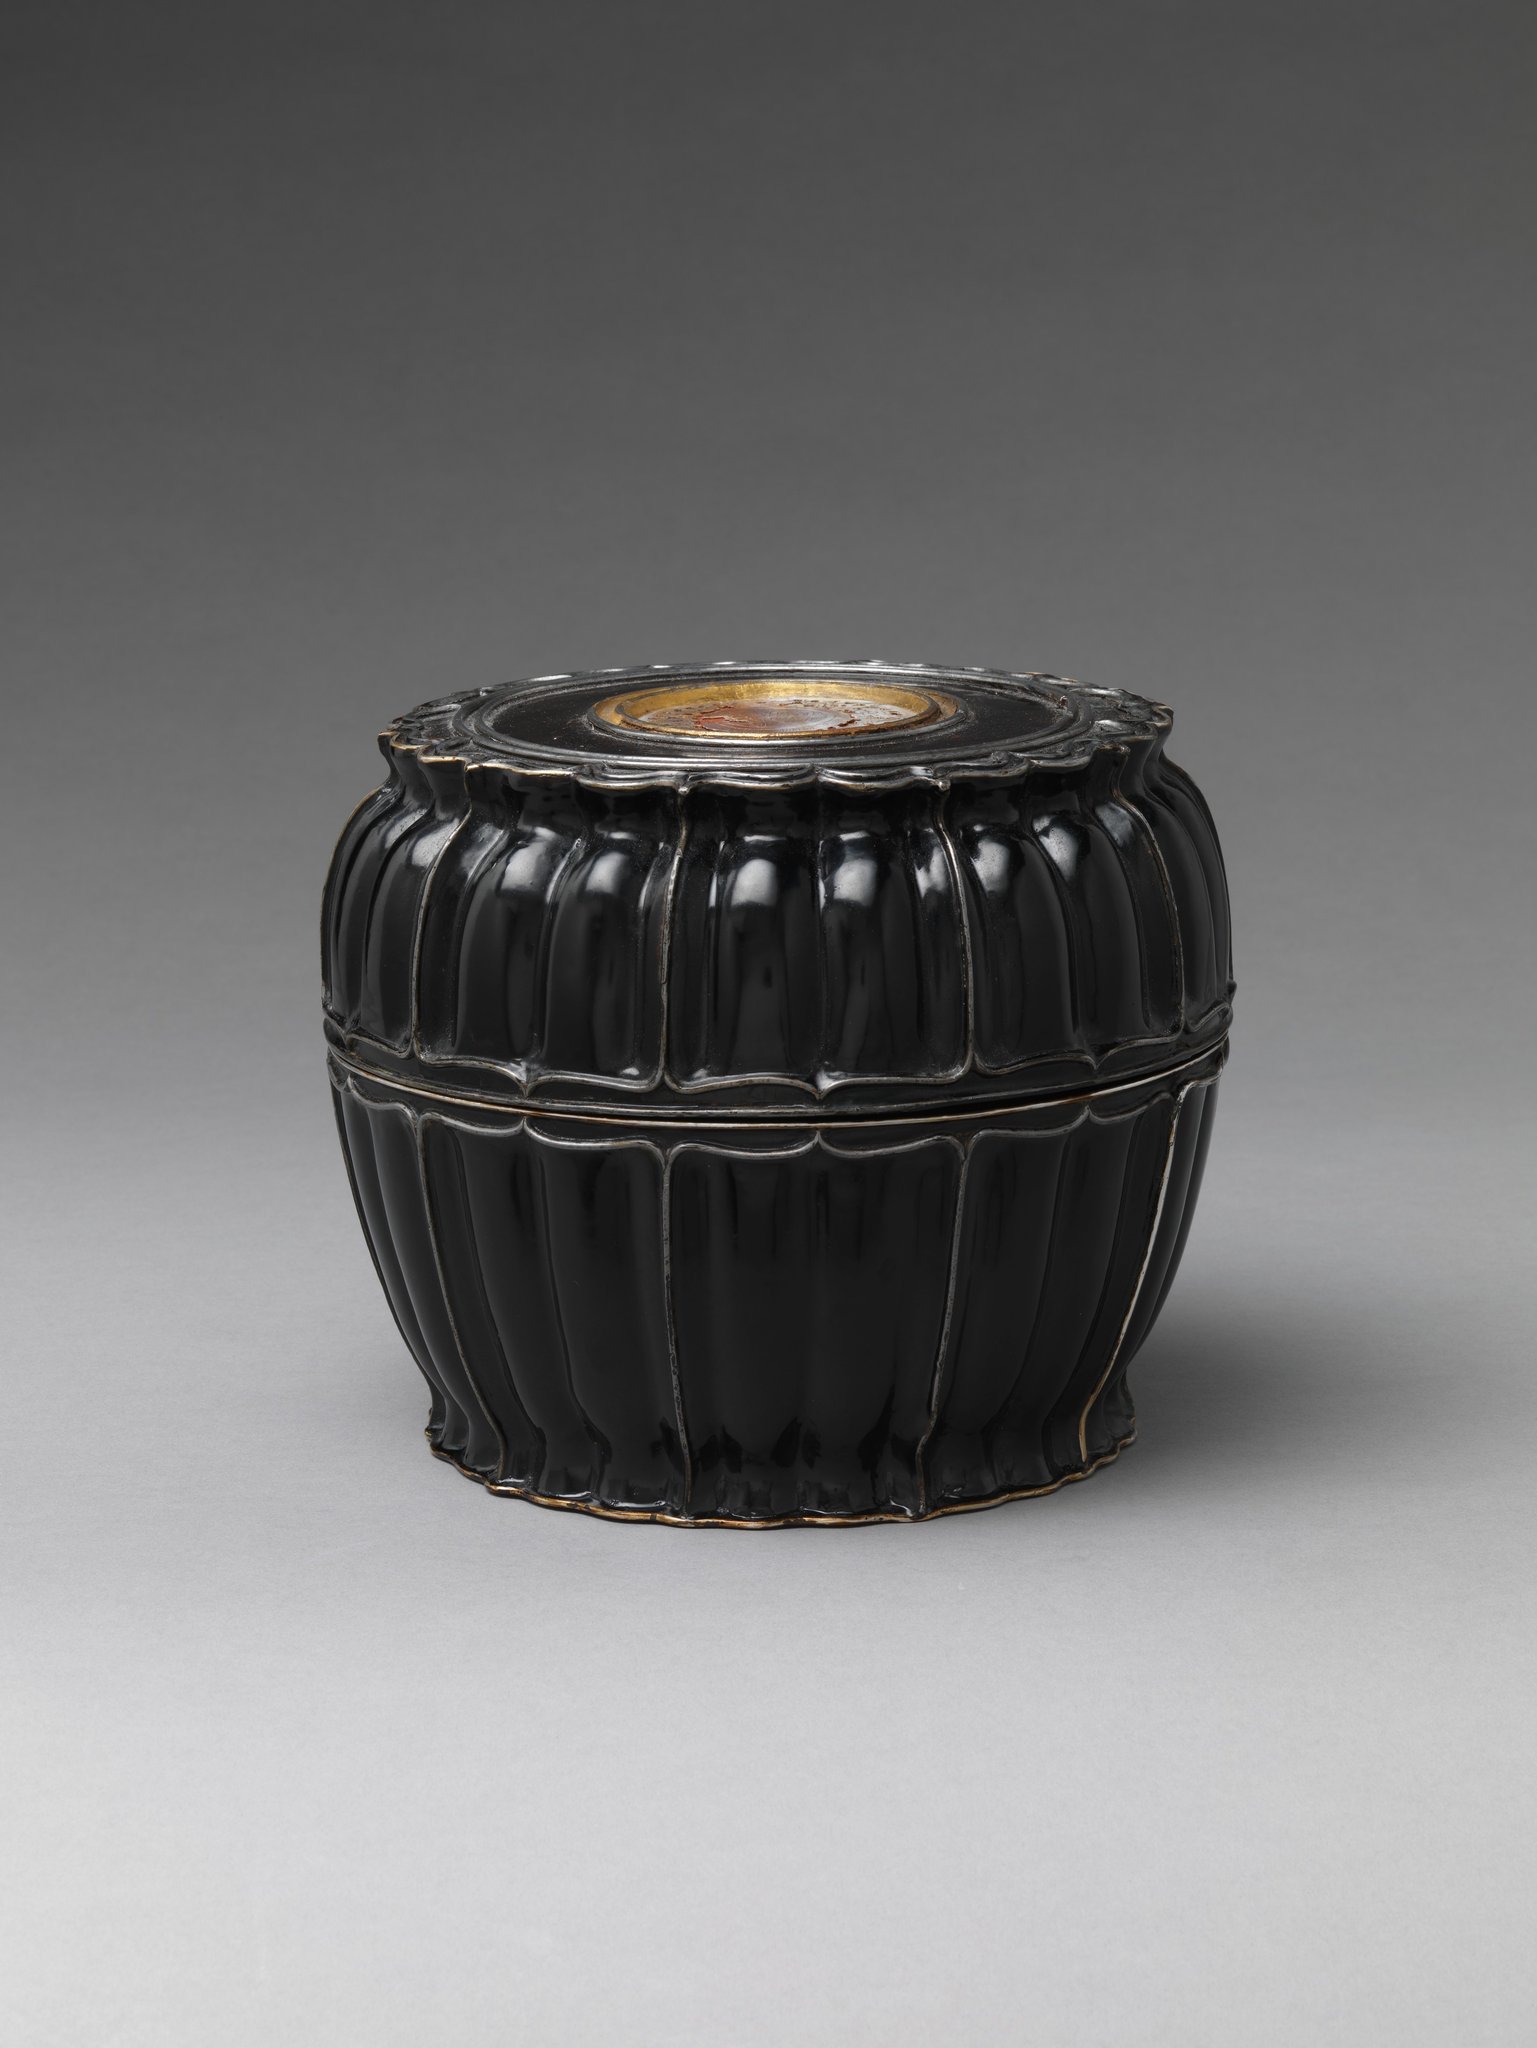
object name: box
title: Covered box with lotus-petal rim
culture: chinese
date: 1267-1400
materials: lacquer, mother of pearl, pewter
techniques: inlay